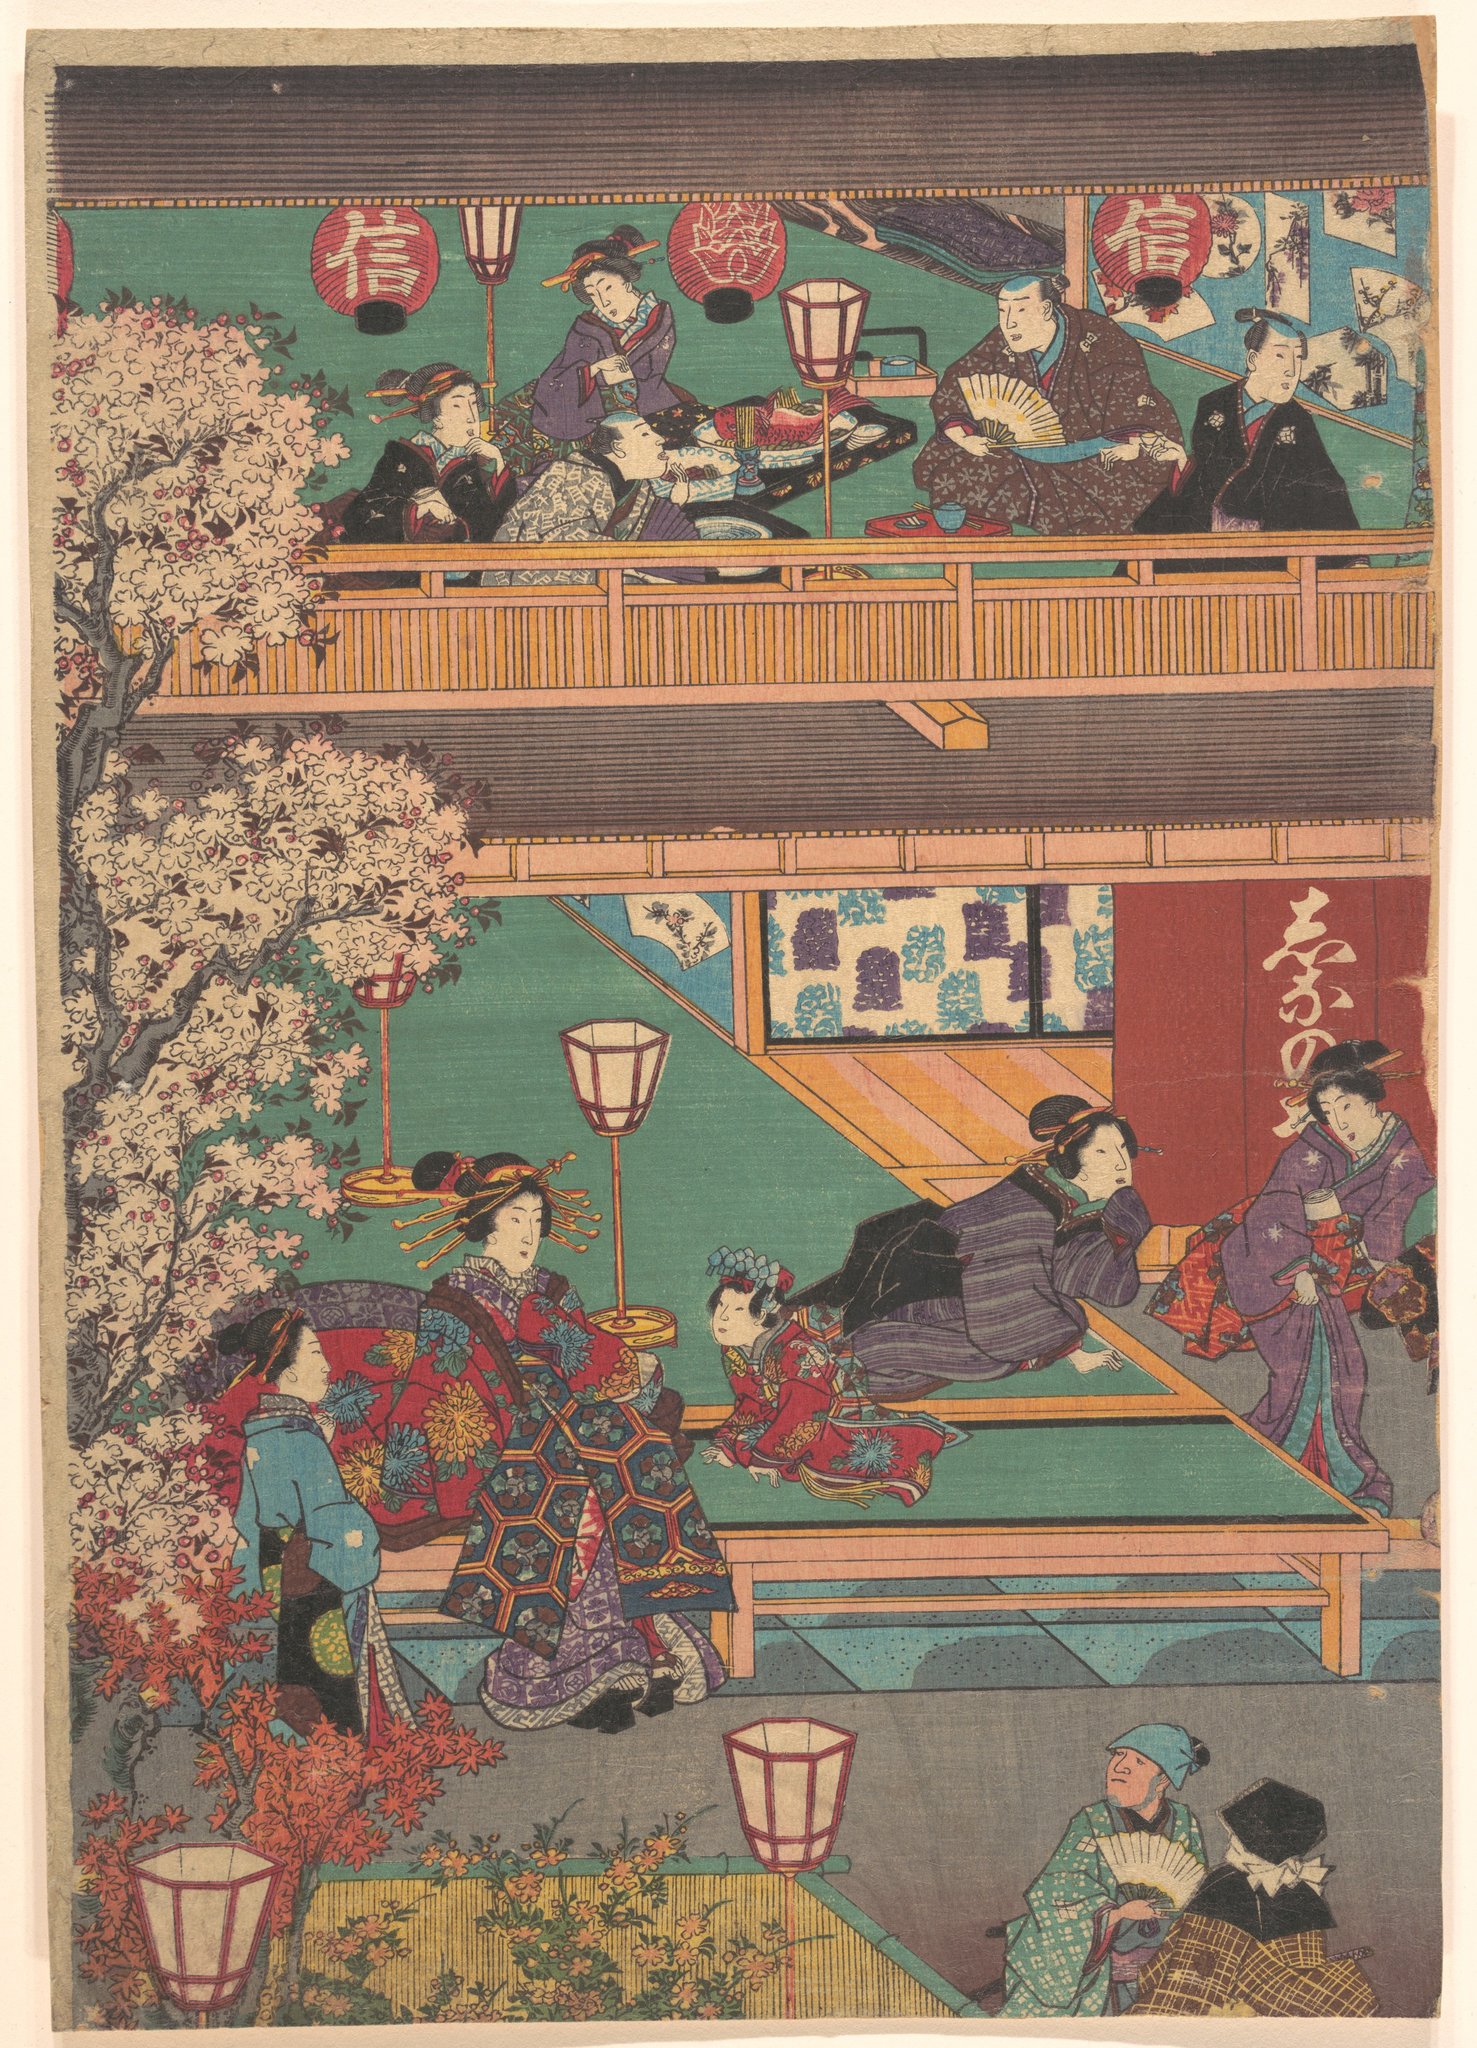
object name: print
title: Early Evening in Yoshiwara Inn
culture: japanese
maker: unidentified artist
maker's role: artist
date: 1801-1900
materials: ink, paper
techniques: woodblock print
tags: inns,interiors,men,women